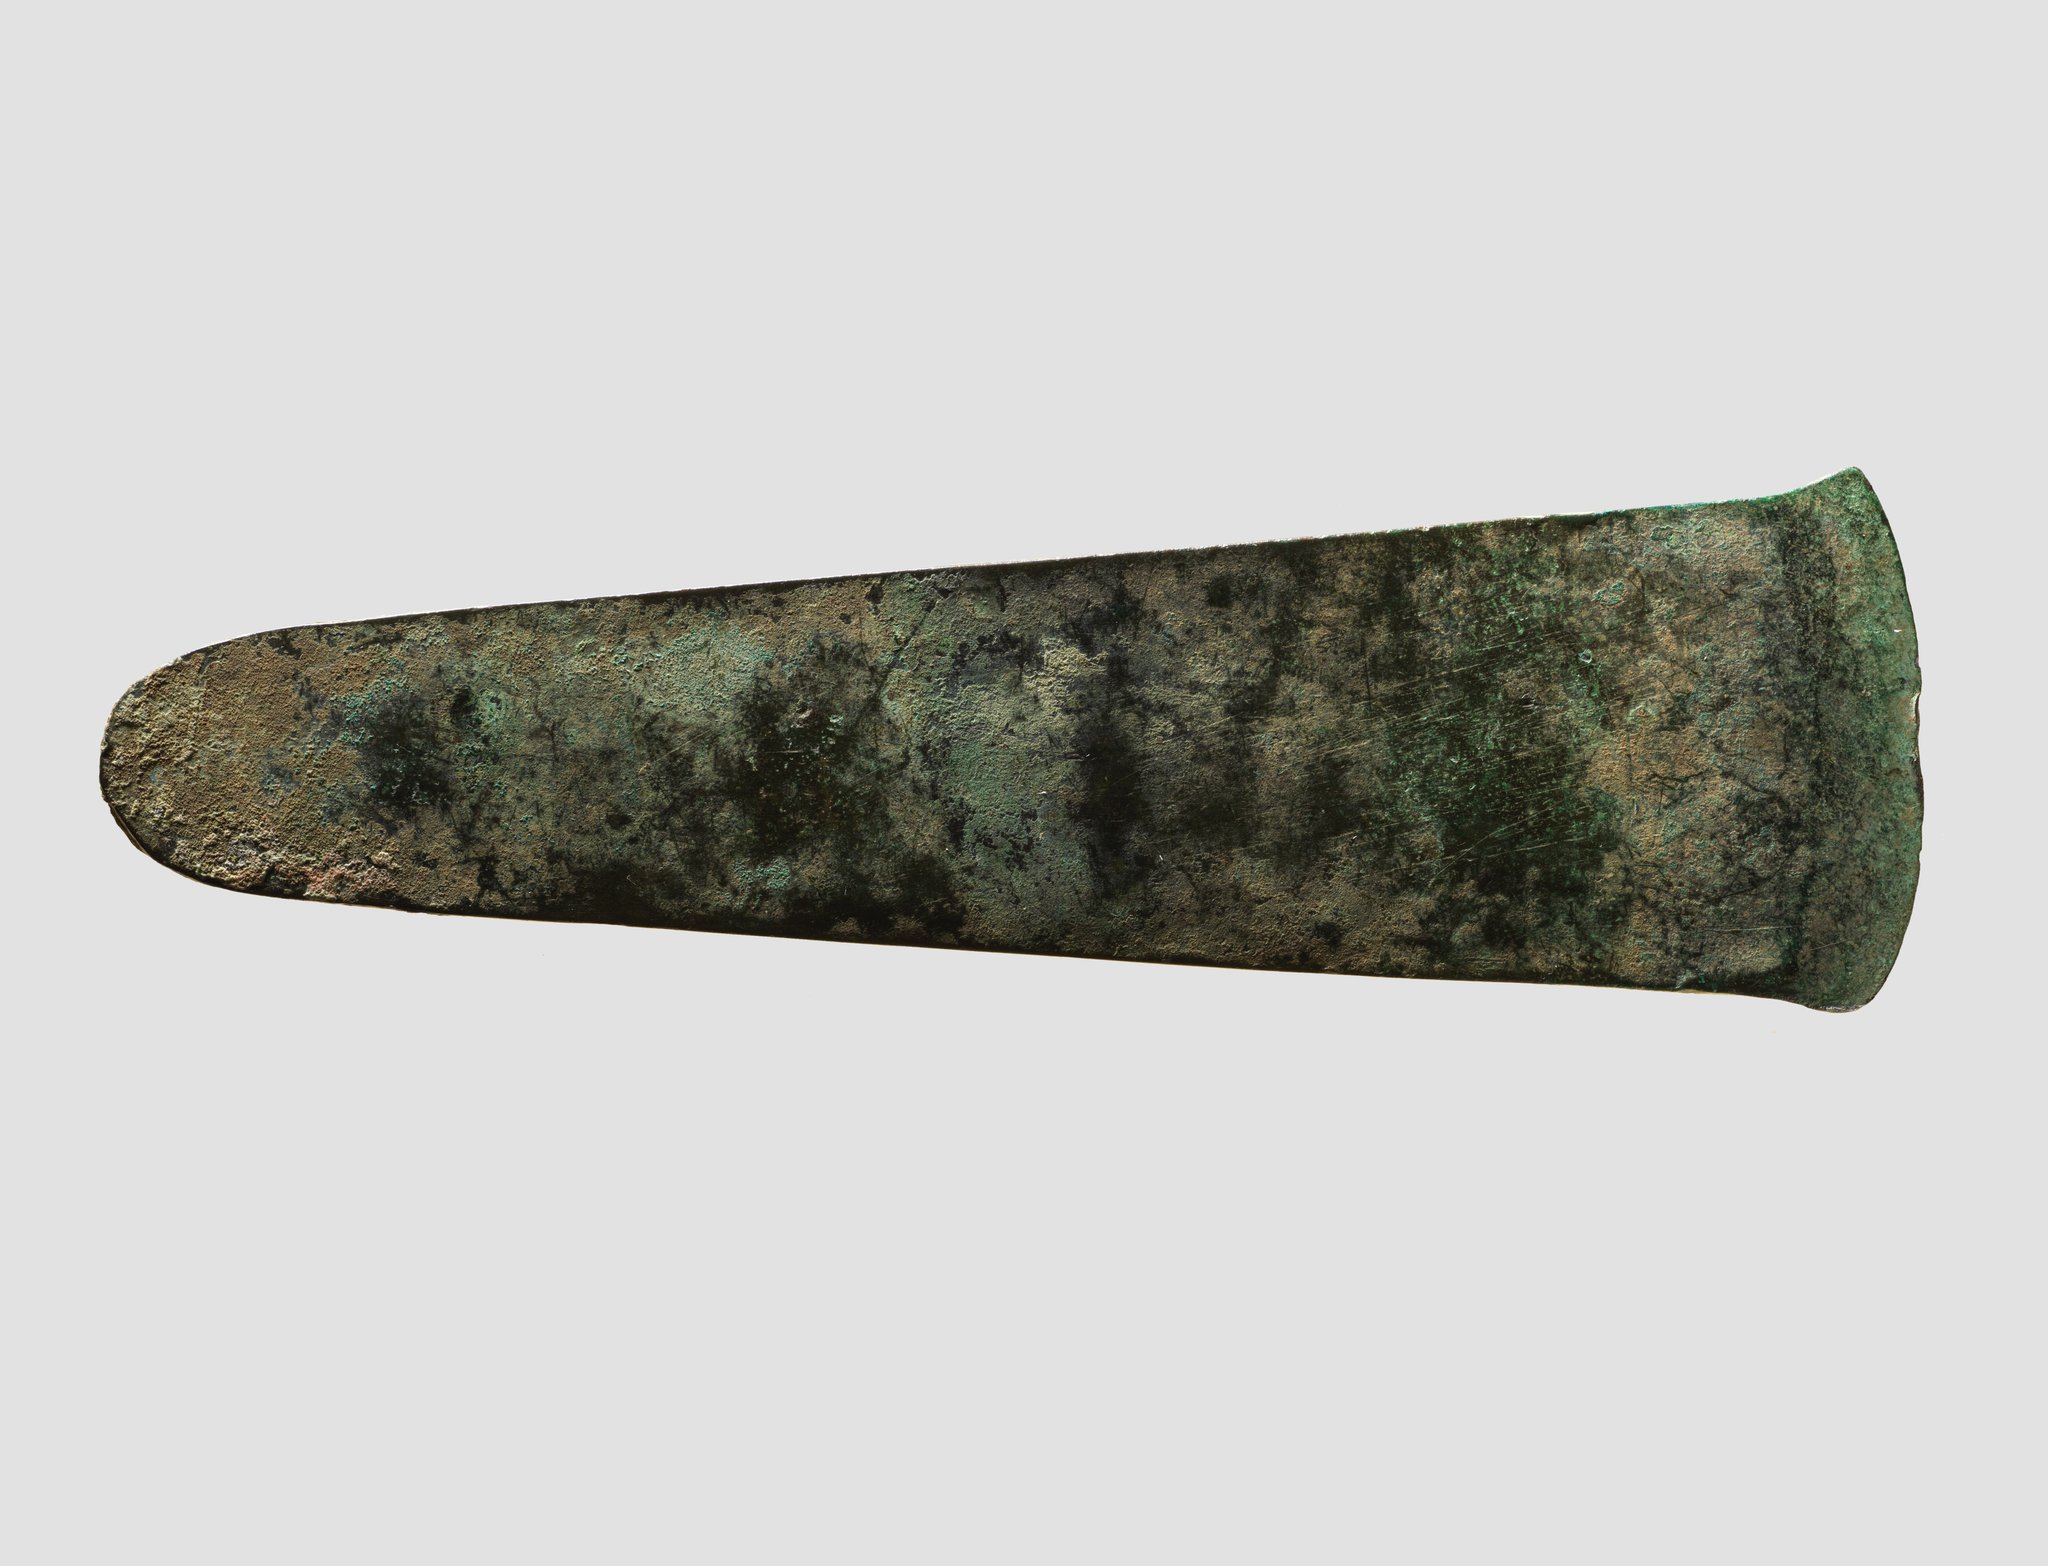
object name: axe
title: Axe head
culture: hattian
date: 2300-2000 BCE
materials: bronze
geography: central anatolia